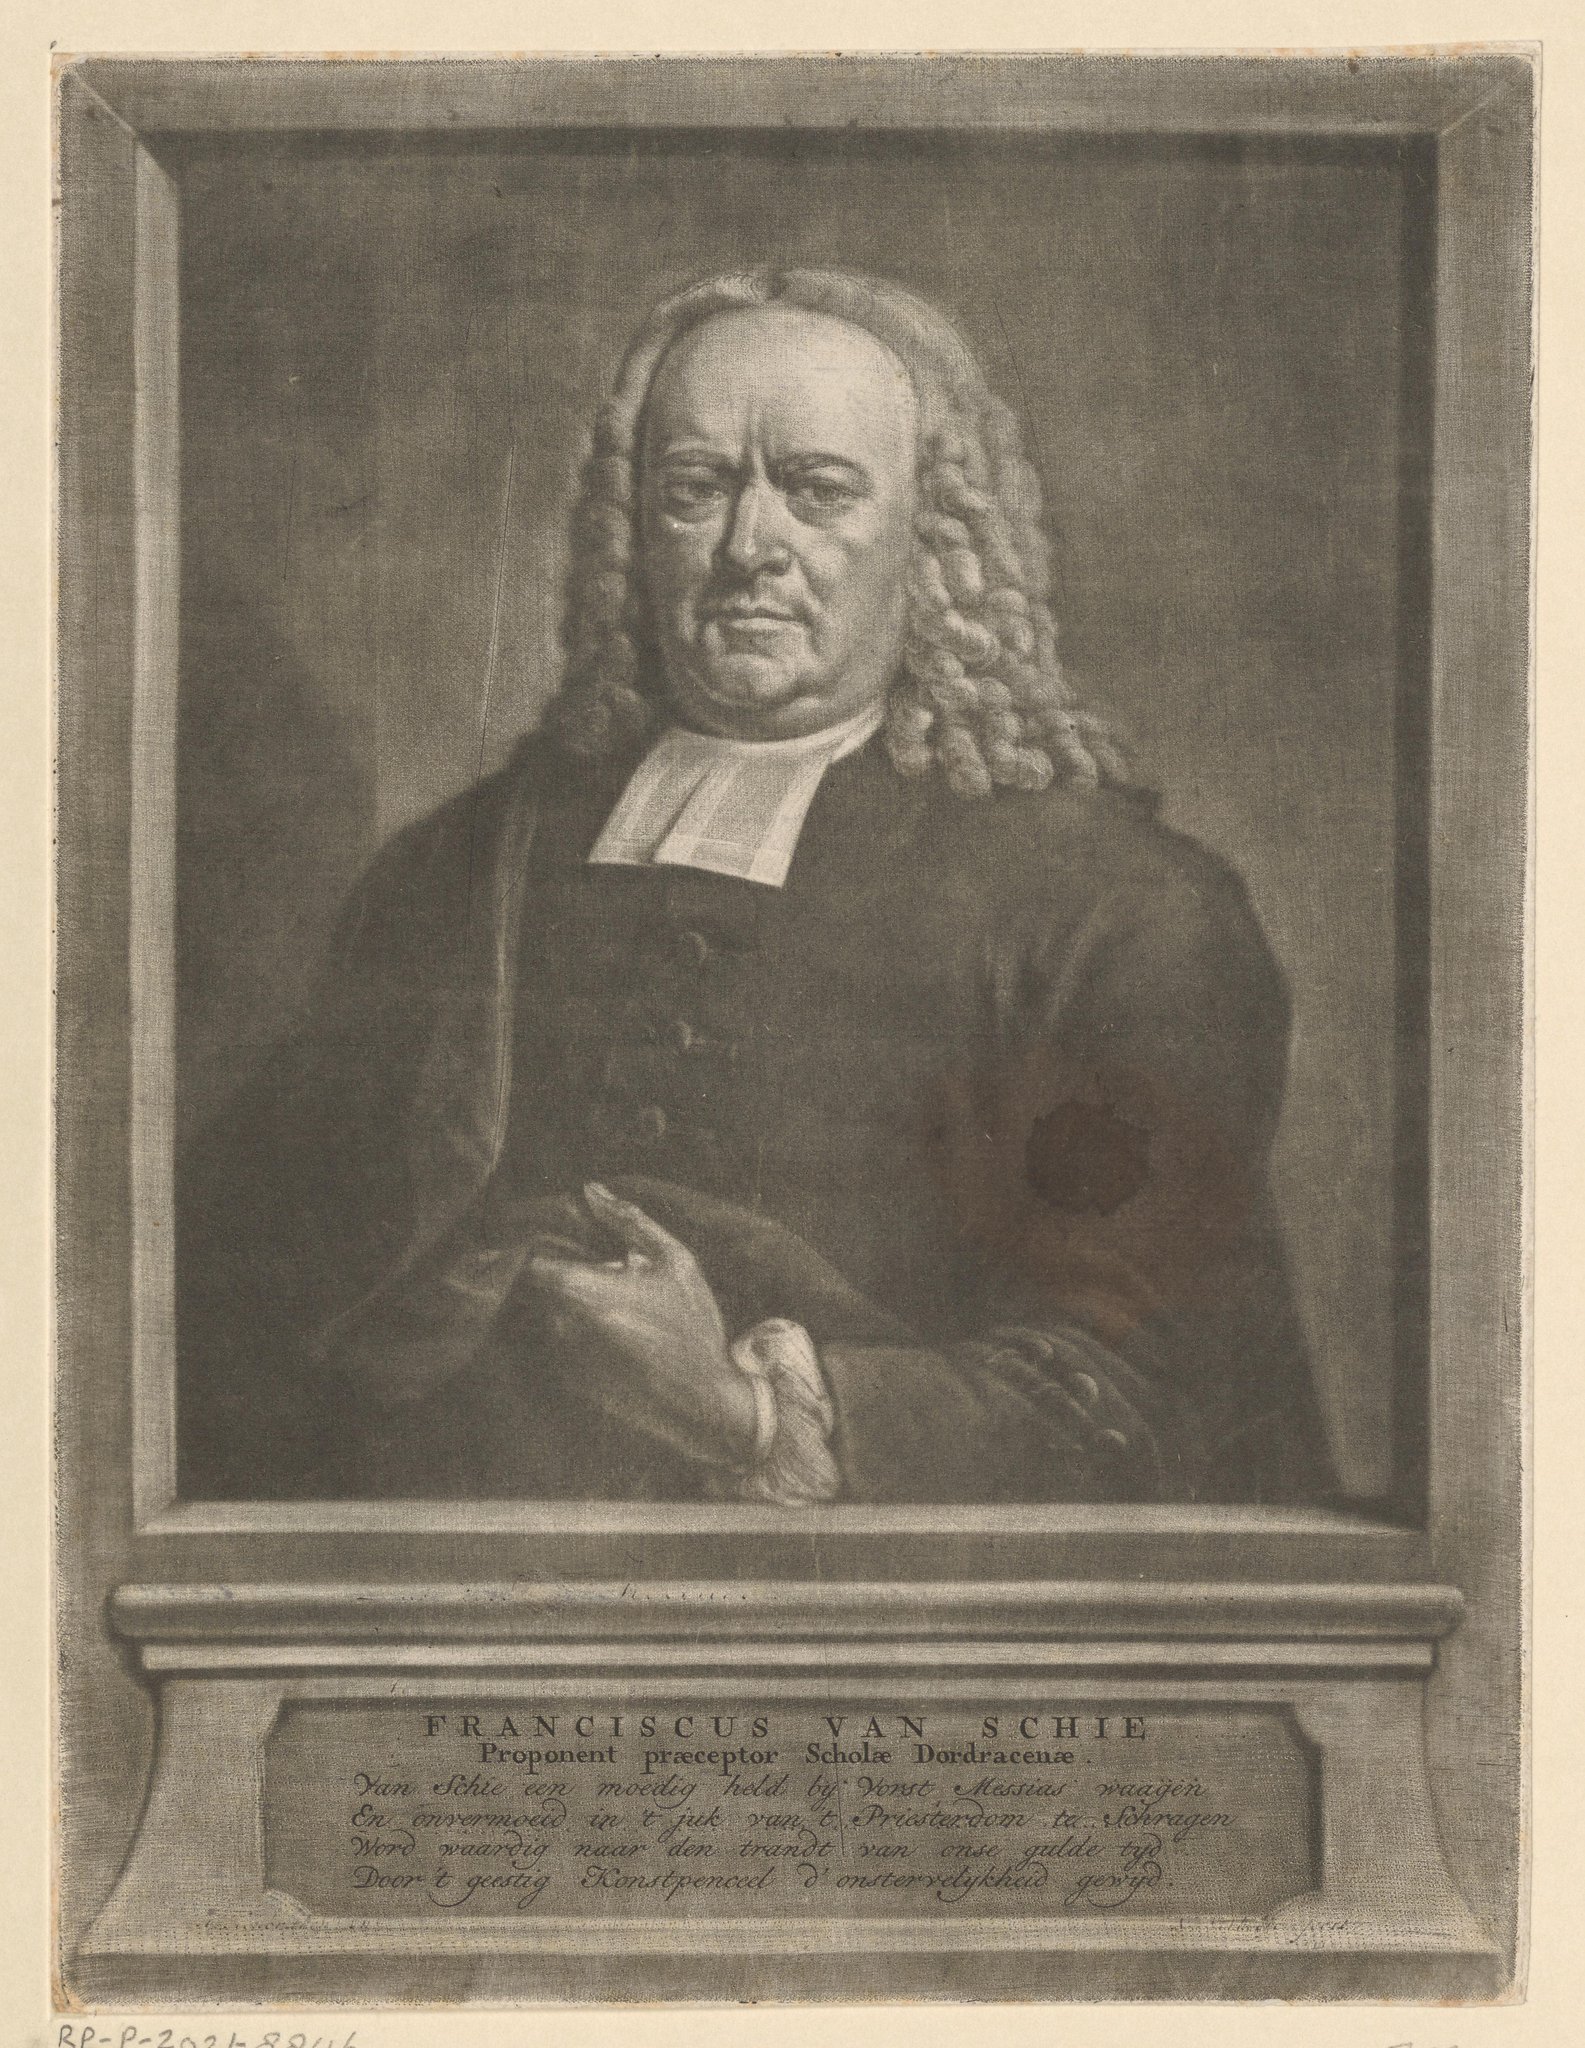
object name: print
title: Portret van Franciscus van Schie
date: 1683-1746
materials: paper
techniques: engraving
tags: protestant churches and denominations, historical persons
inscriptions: inscription